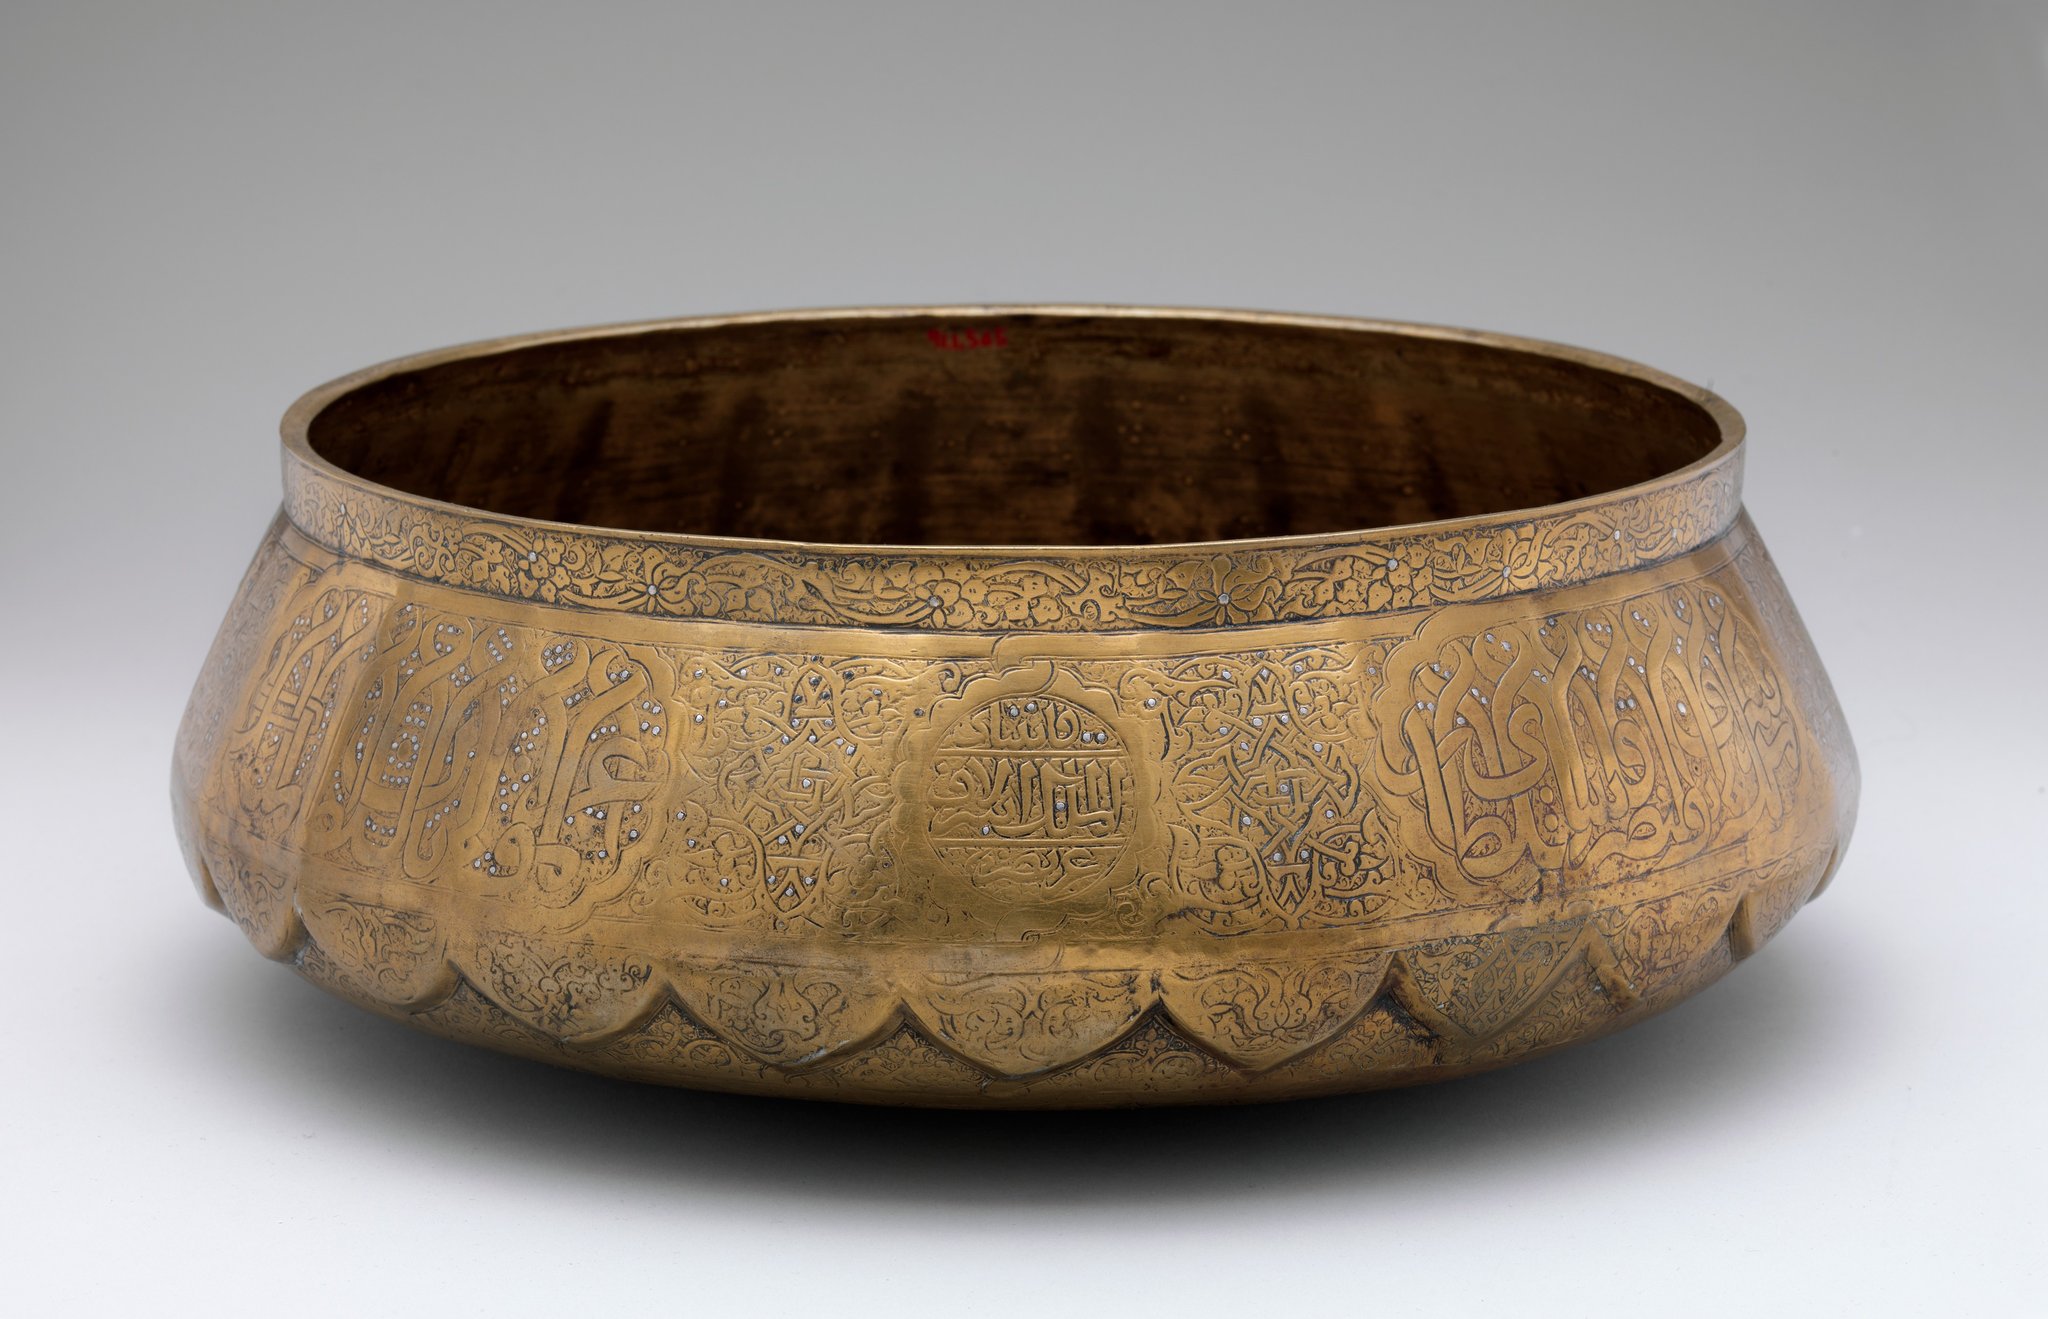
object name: basin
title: Basin of Sultan Qaytbay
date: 1468-1496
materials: brass, silver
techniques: inlay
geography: egypt or syria